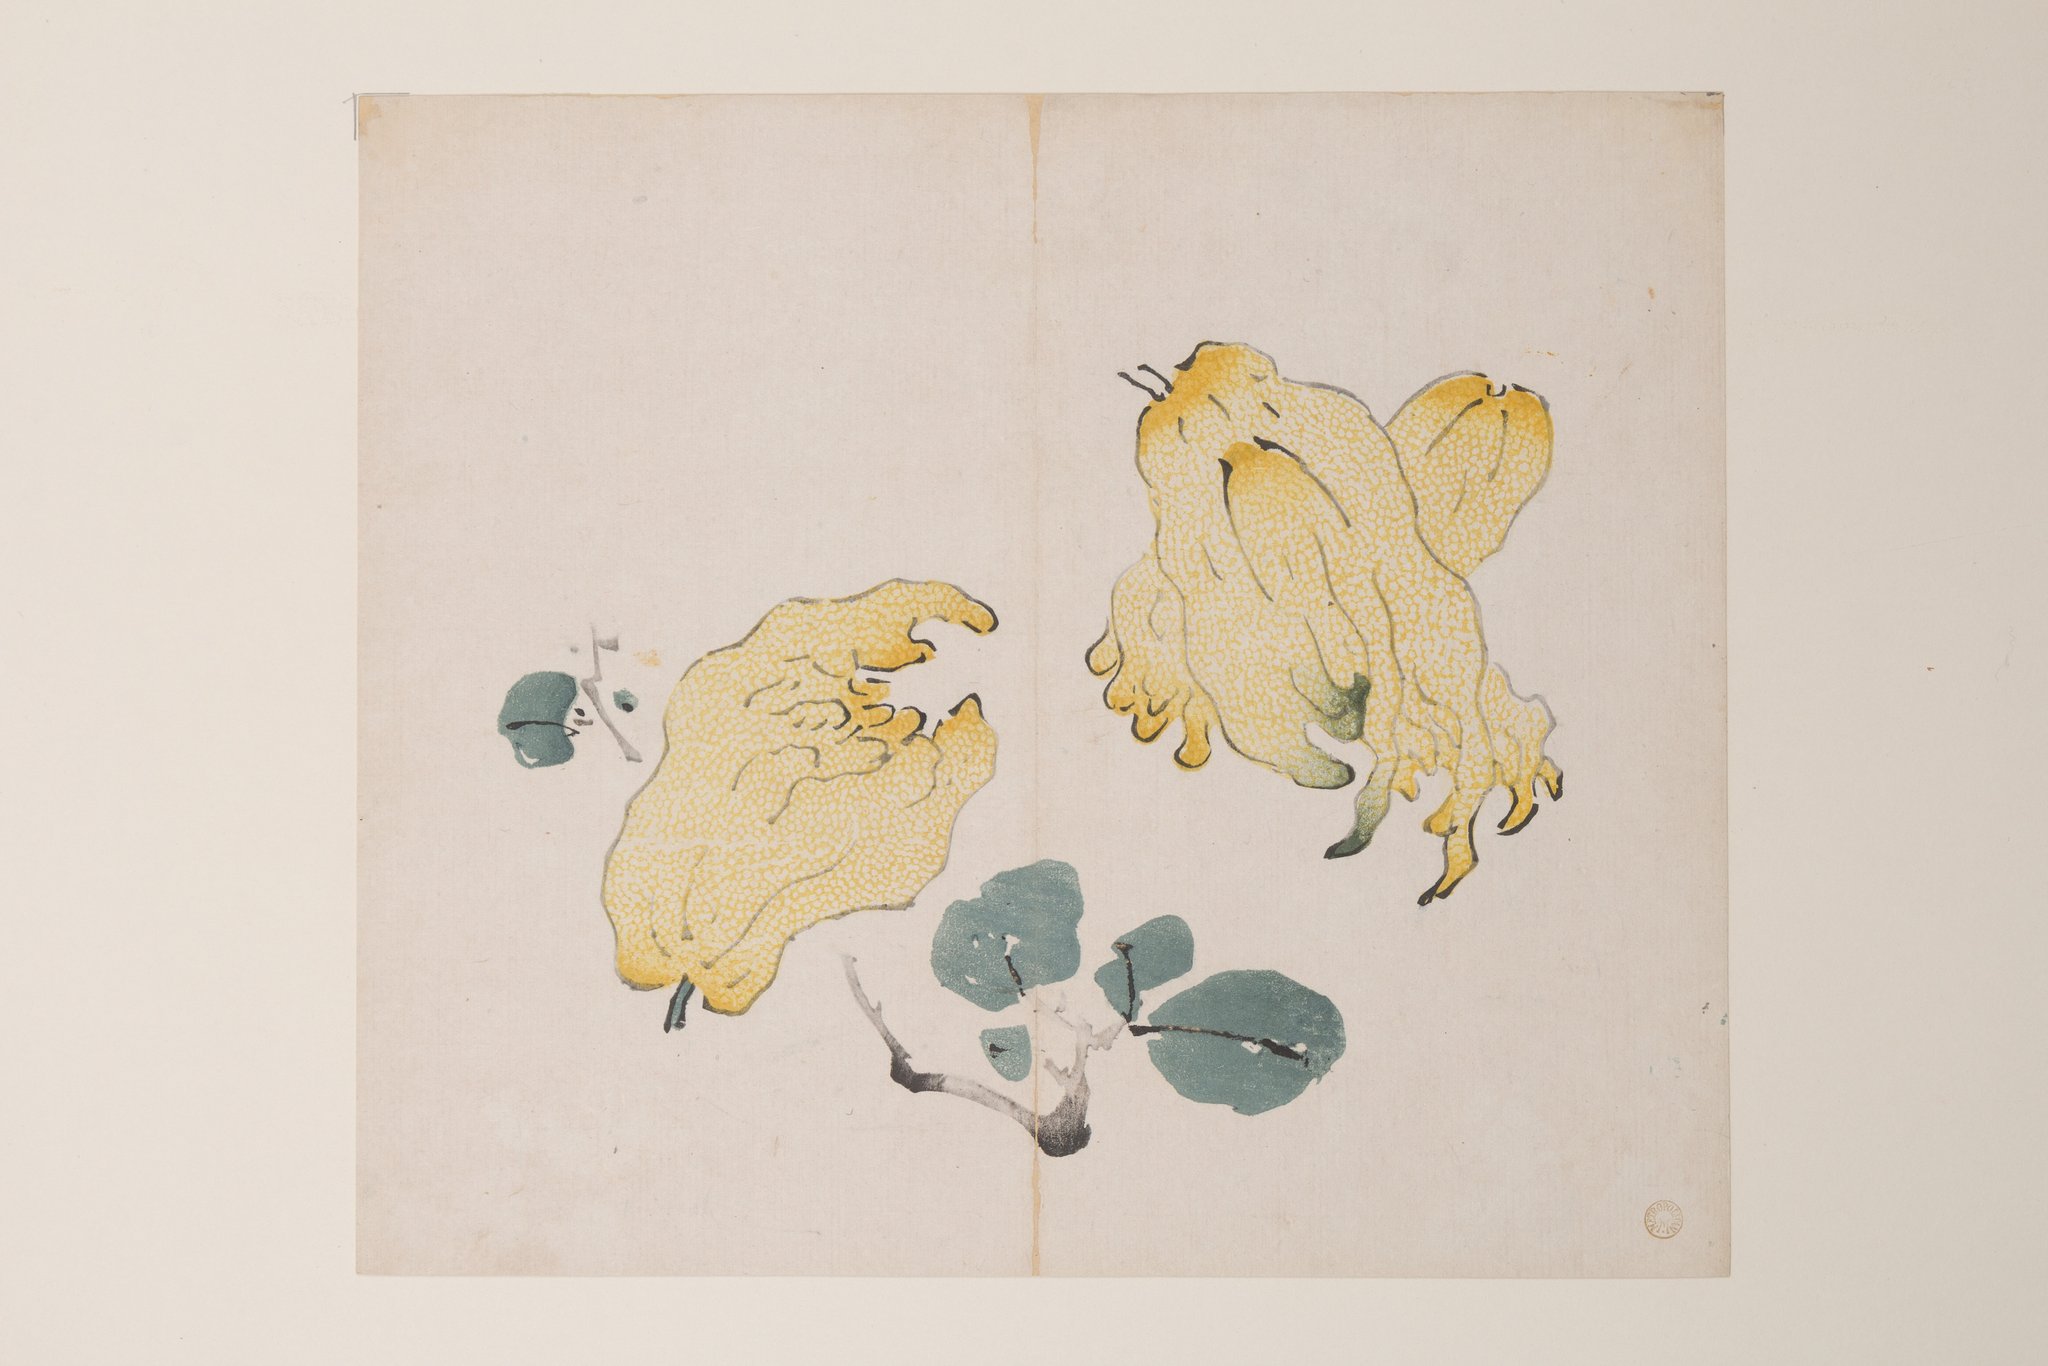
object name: print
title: Page from the Ten Bamboo Studio Manual of Painting and Calligraphy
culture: chinese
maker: hu zhengyan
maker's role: artist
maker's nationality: chinese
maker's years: 1584-1634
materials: ink, paper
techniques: printing